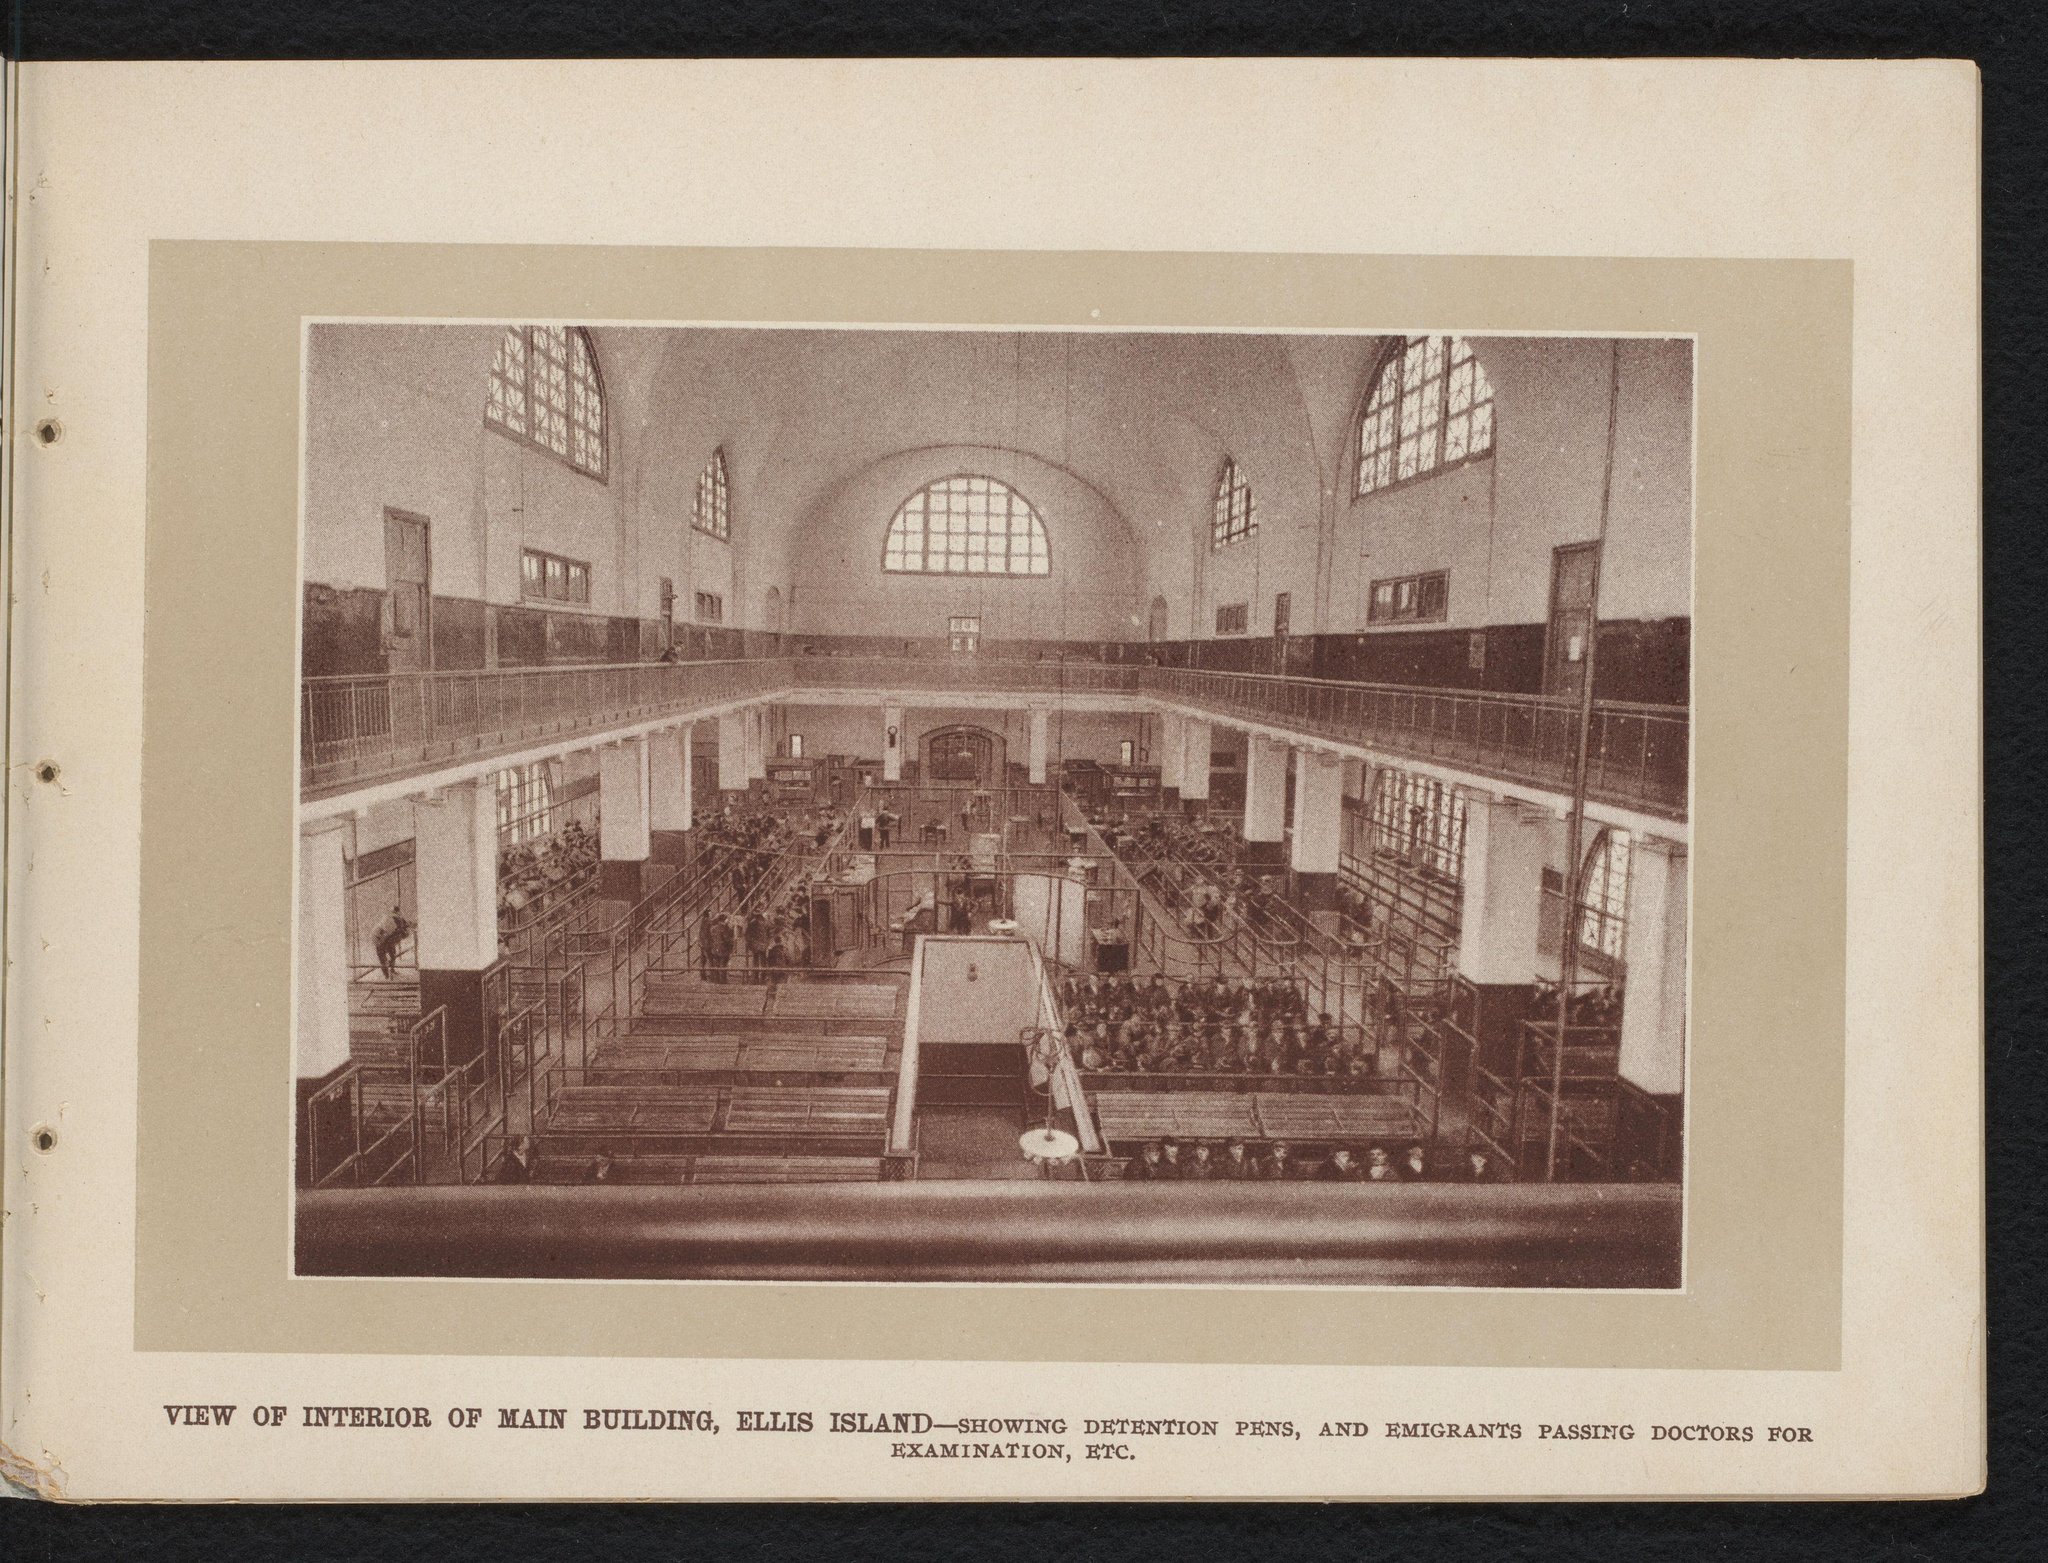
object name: page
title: View of interior of main building, Ellis Island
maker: Anonymous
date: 1897-1902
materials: paper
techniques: autotype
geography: new york city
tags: institution for contagious diseases, (descendants of) european emigrants to america, diseases